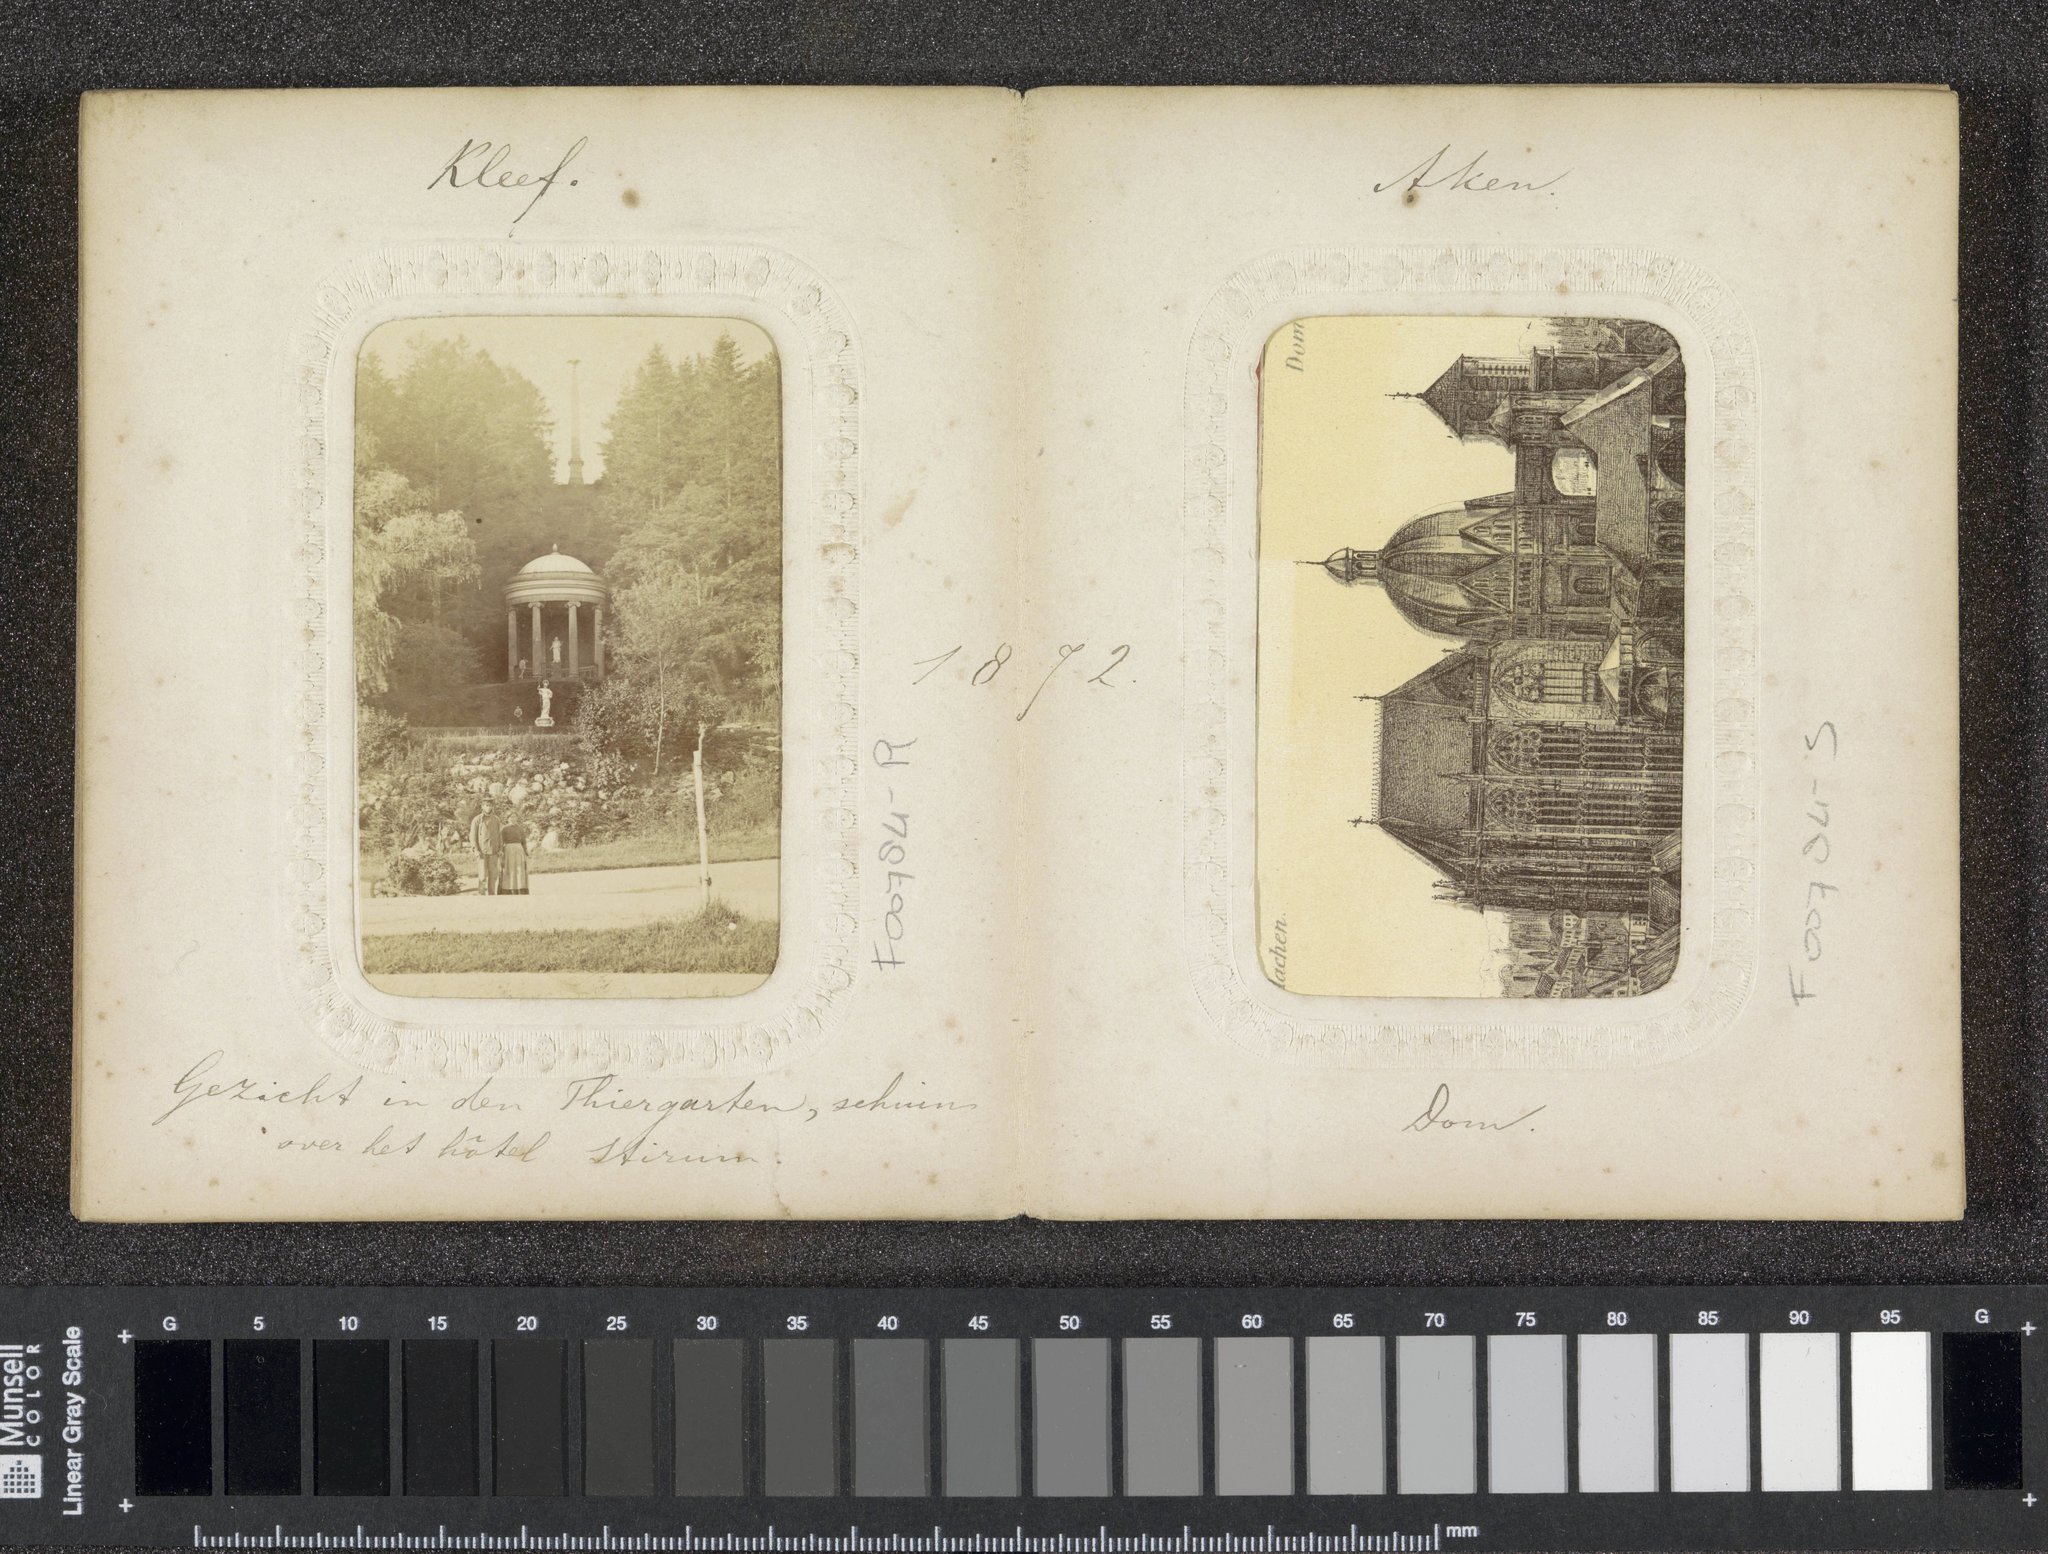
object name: album leaf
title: Aken. Dom.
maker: Anonymous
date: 1872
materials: cardboard, paper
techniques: lithograph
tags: church (exterior), dome ~ architecture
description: Onderdeel van Fotoalbum met bezienswaardigheden in Nederlandse, Belgische en Duitse steden.